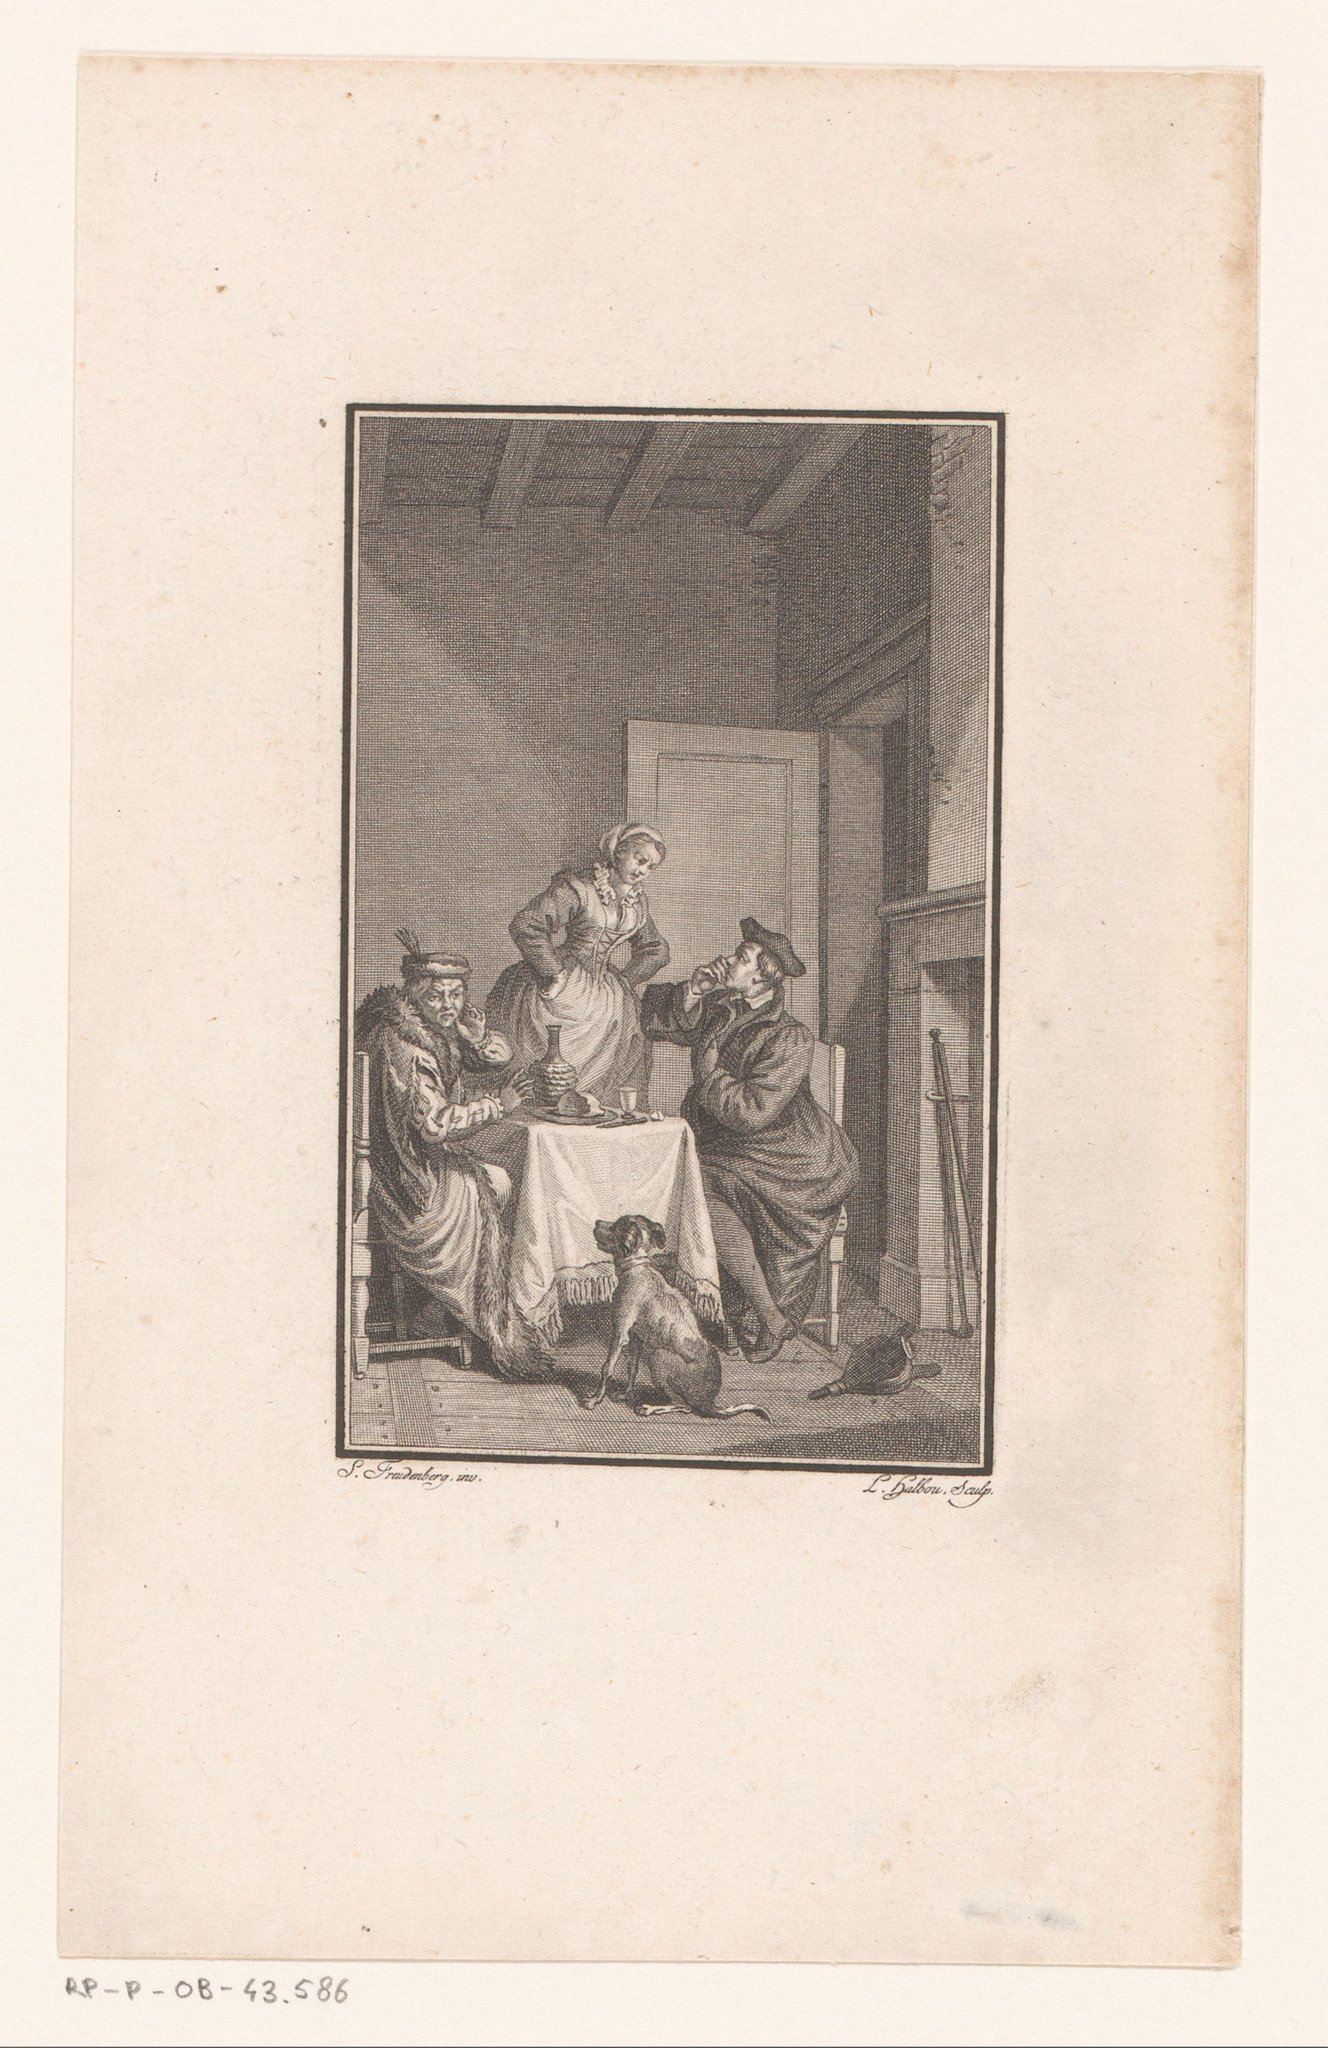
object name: print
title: Twee mannen aan een tafel met een boze keukenmeid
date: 1781-1782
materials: paper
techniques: etching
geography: bern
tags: evening meal, dinner, supper, kitchen-maid, kitchen servant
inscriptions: collector's mark: Lugt 2228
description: Prent uit: Les Nouvelles de Marguerite, reine de Navarre. Bern: la nouvelle Société Typographique, 1780-1781.